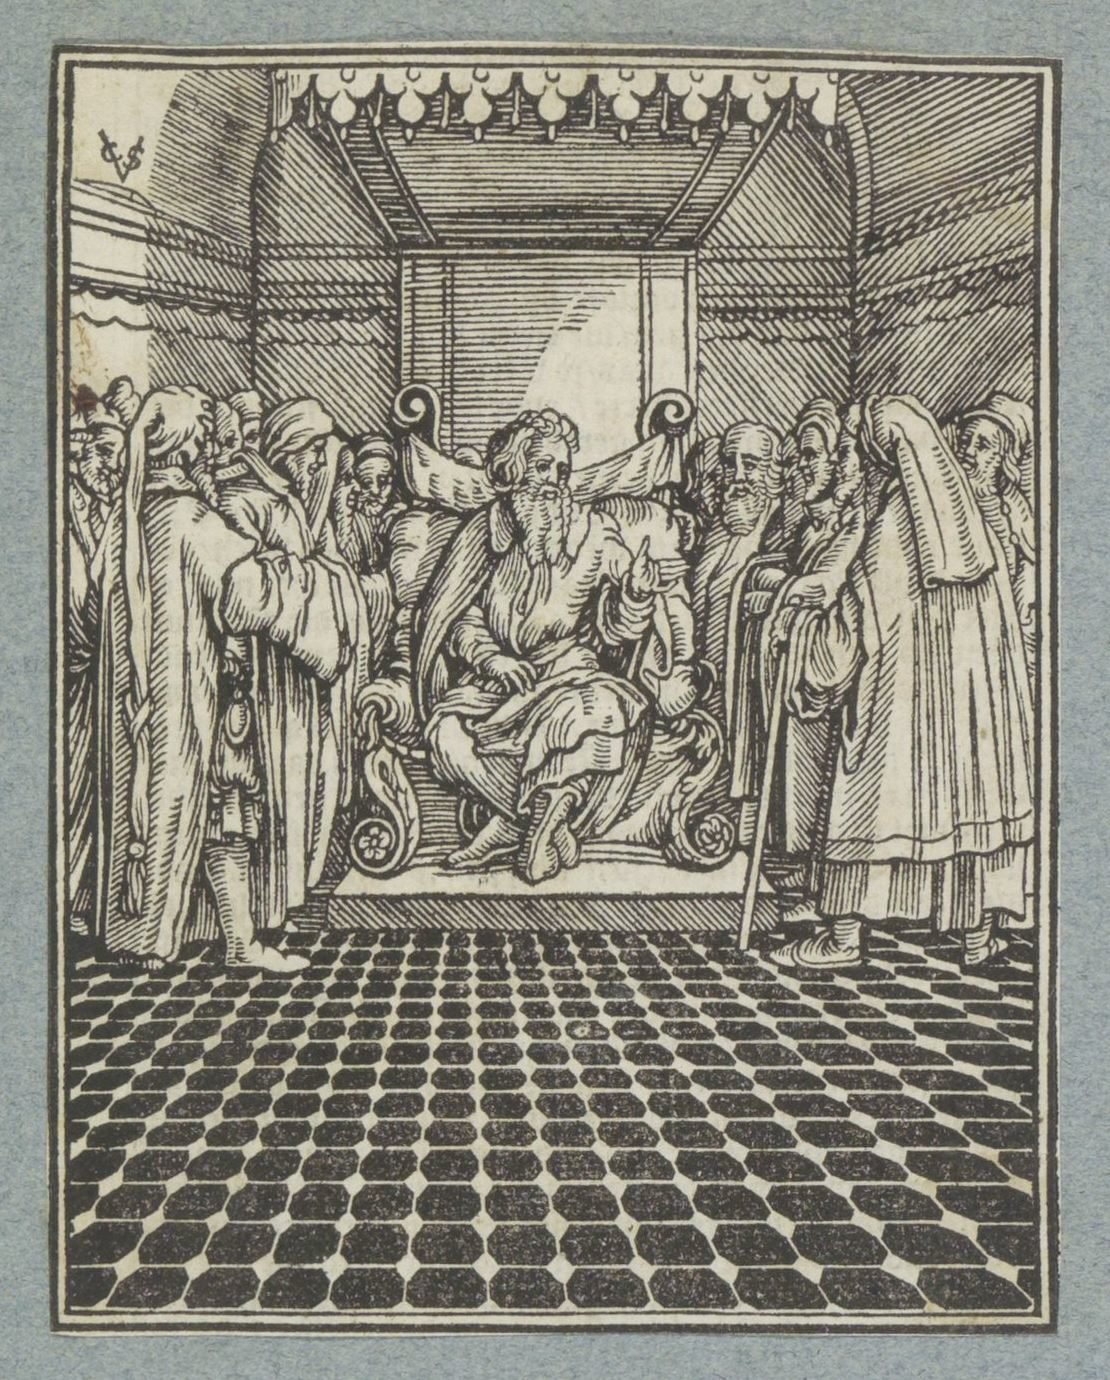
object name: album leaf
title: Oude mannen verenigd rond een troon met stamvader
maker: pieter jacobsz. paets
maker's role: publisher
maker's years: 1587-1667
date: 1645-1646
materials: paper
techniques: letterpress printing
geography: amsterdam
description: De prent werd gemaakt voor de uitgaven van P.J. Paets uit Amsterdam. Ze komt in ieder geval voor in: Bibels Tresoor ofte der zielen lusthof. Amsterdam, P.J. Paets, 1646. Mogelijk ook in: Historien ende Prophetien. [Amsterdam], P.J. Paets, 1645.